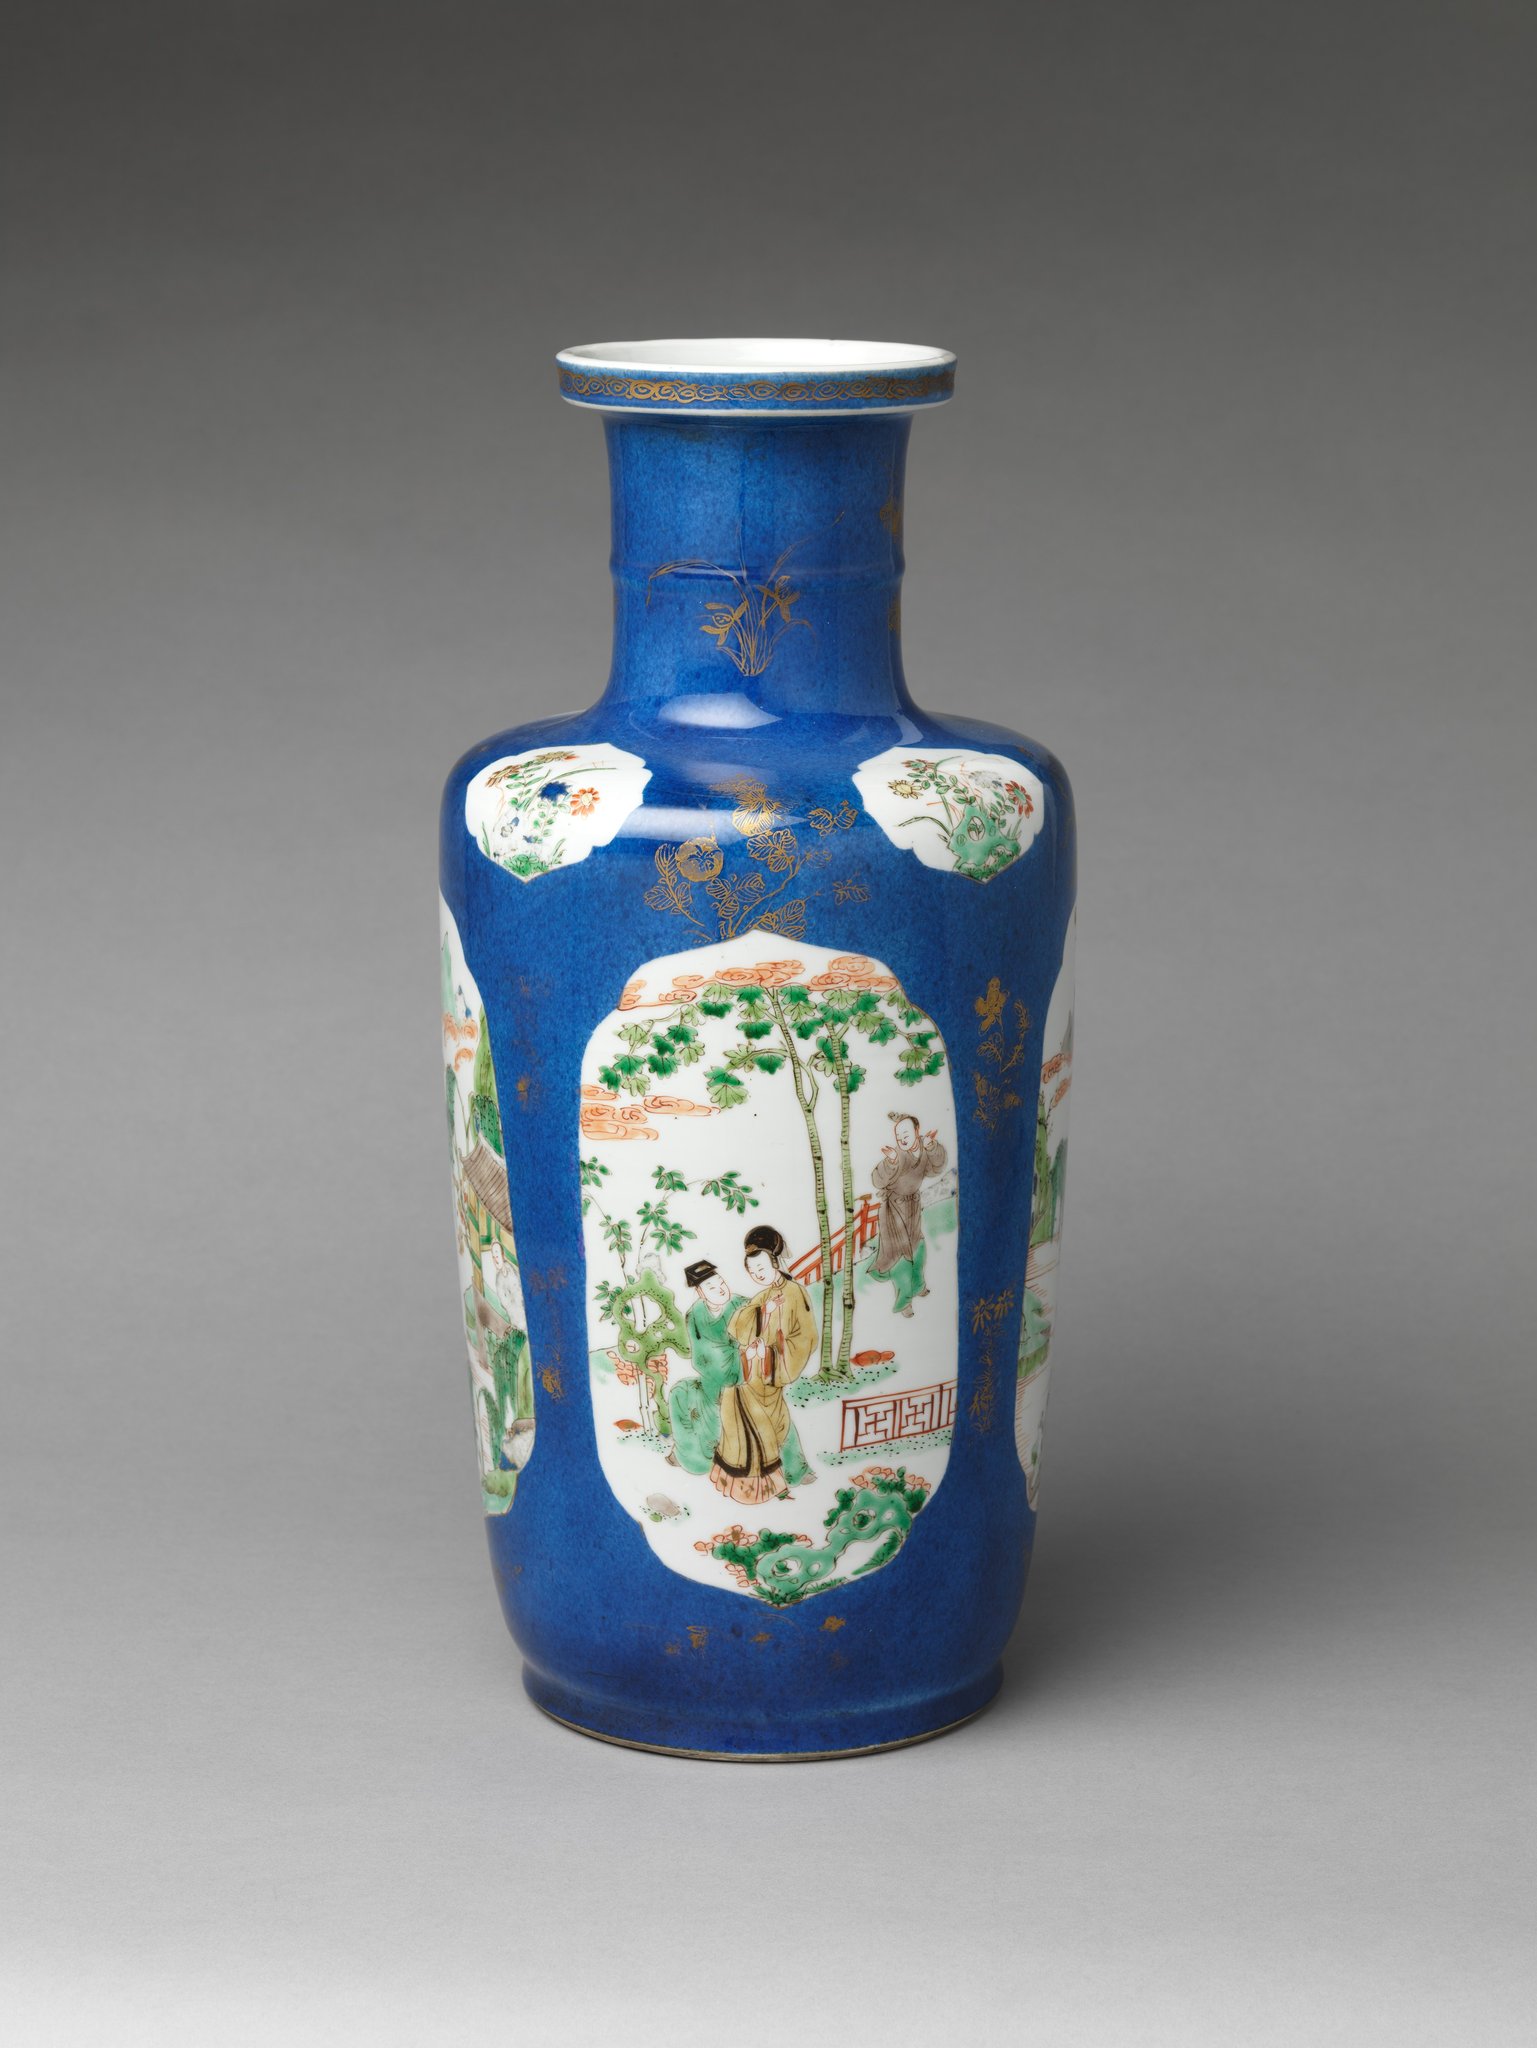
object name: vase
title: Vase with romantic scenes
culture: chinese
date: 1701-1733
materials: enamel, glaze, gold, porcelain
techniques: painting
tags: couples,men,women